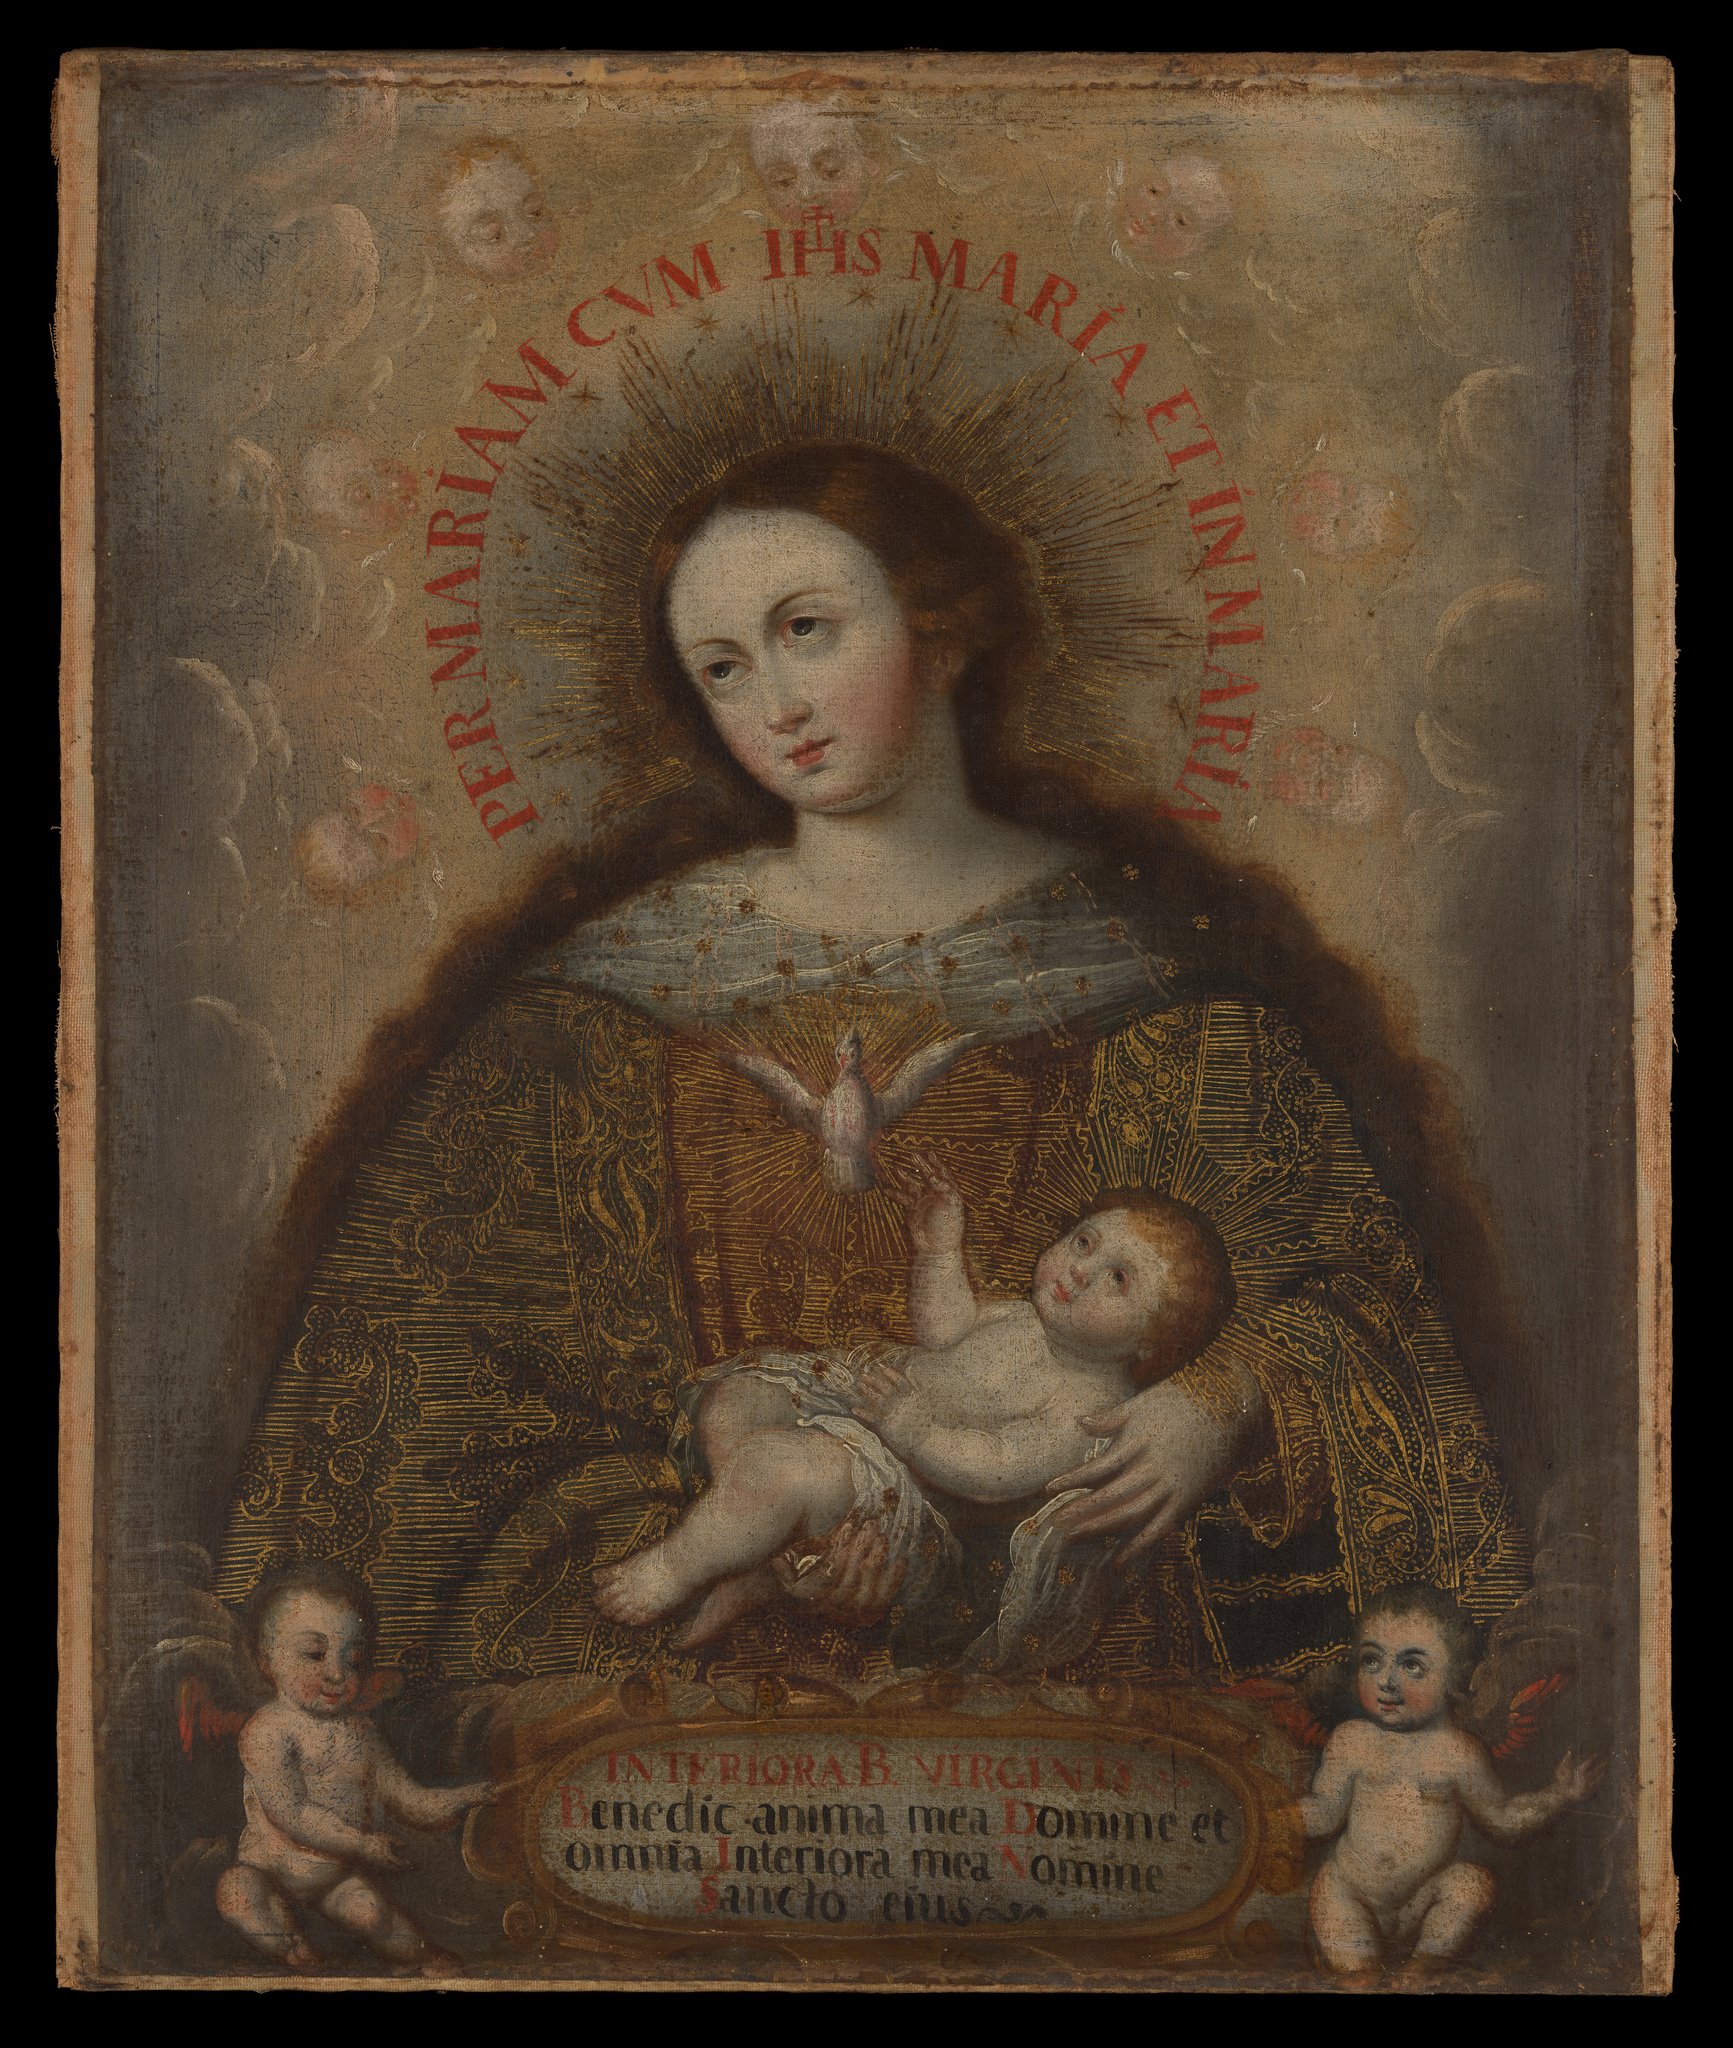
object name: painting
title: The Soul of the Virgin Mary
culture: peruvian, cuzco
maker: Anonymous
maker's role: artist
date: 1701-1800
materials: canvas, gold, oil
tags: madonna and child,virgin mary,jesus